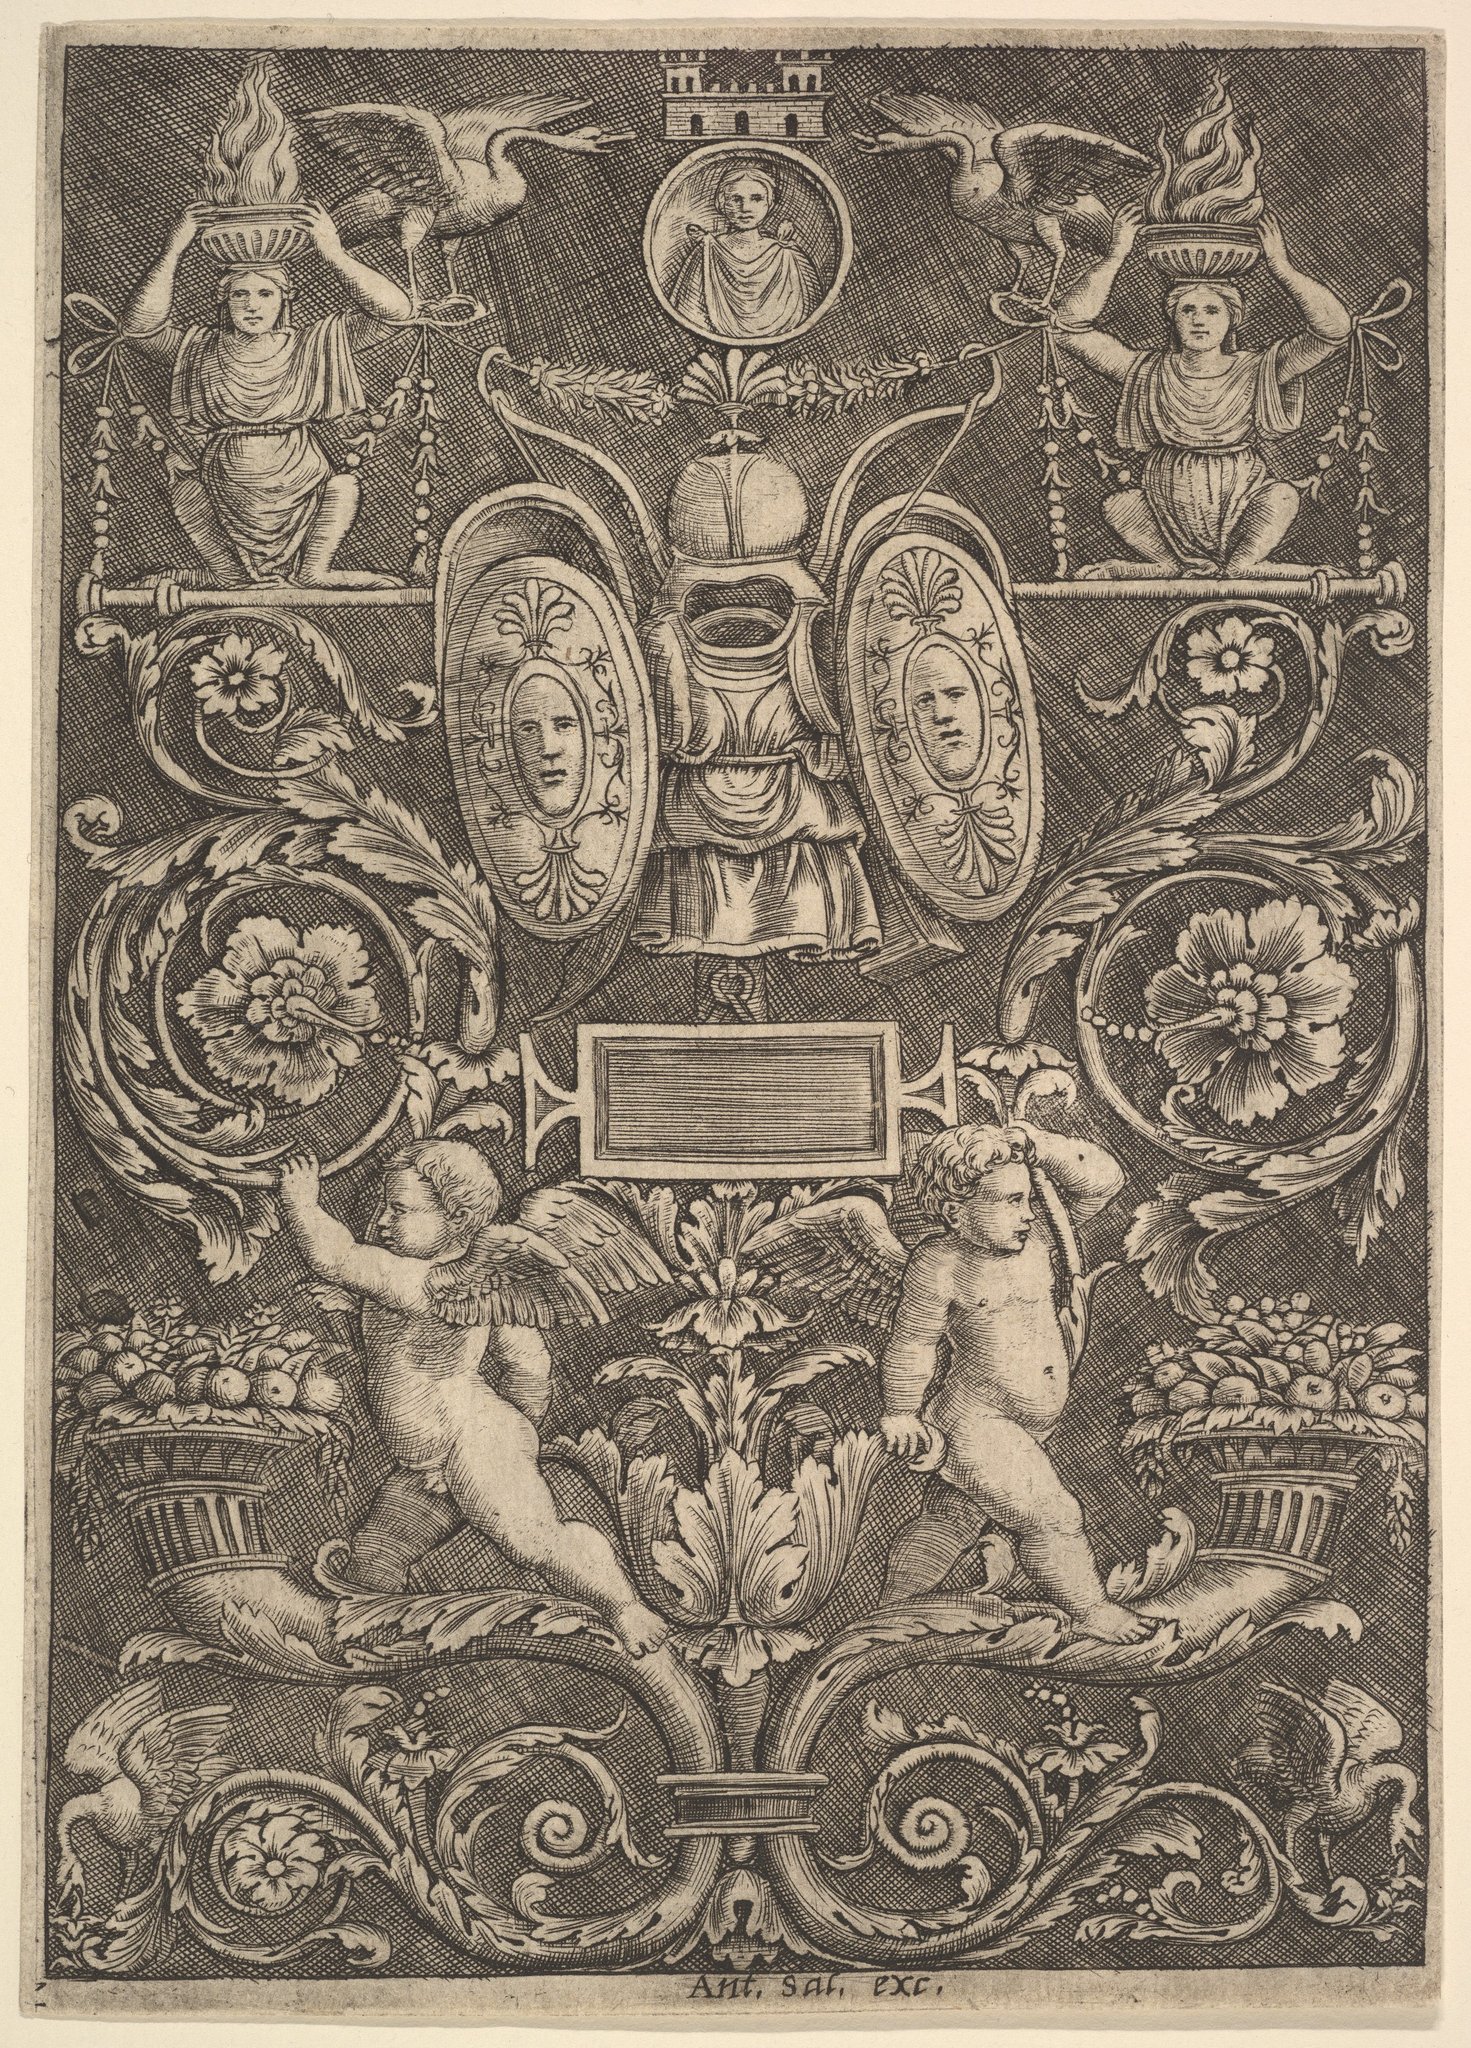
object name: print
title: A panel of ornament, putti standing on cornucopia in lower section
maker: master of the die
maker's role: artist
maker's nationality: italian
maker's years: 1525-1560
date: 1530-1560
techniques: engraving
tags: human figures,cornucopia,flowers